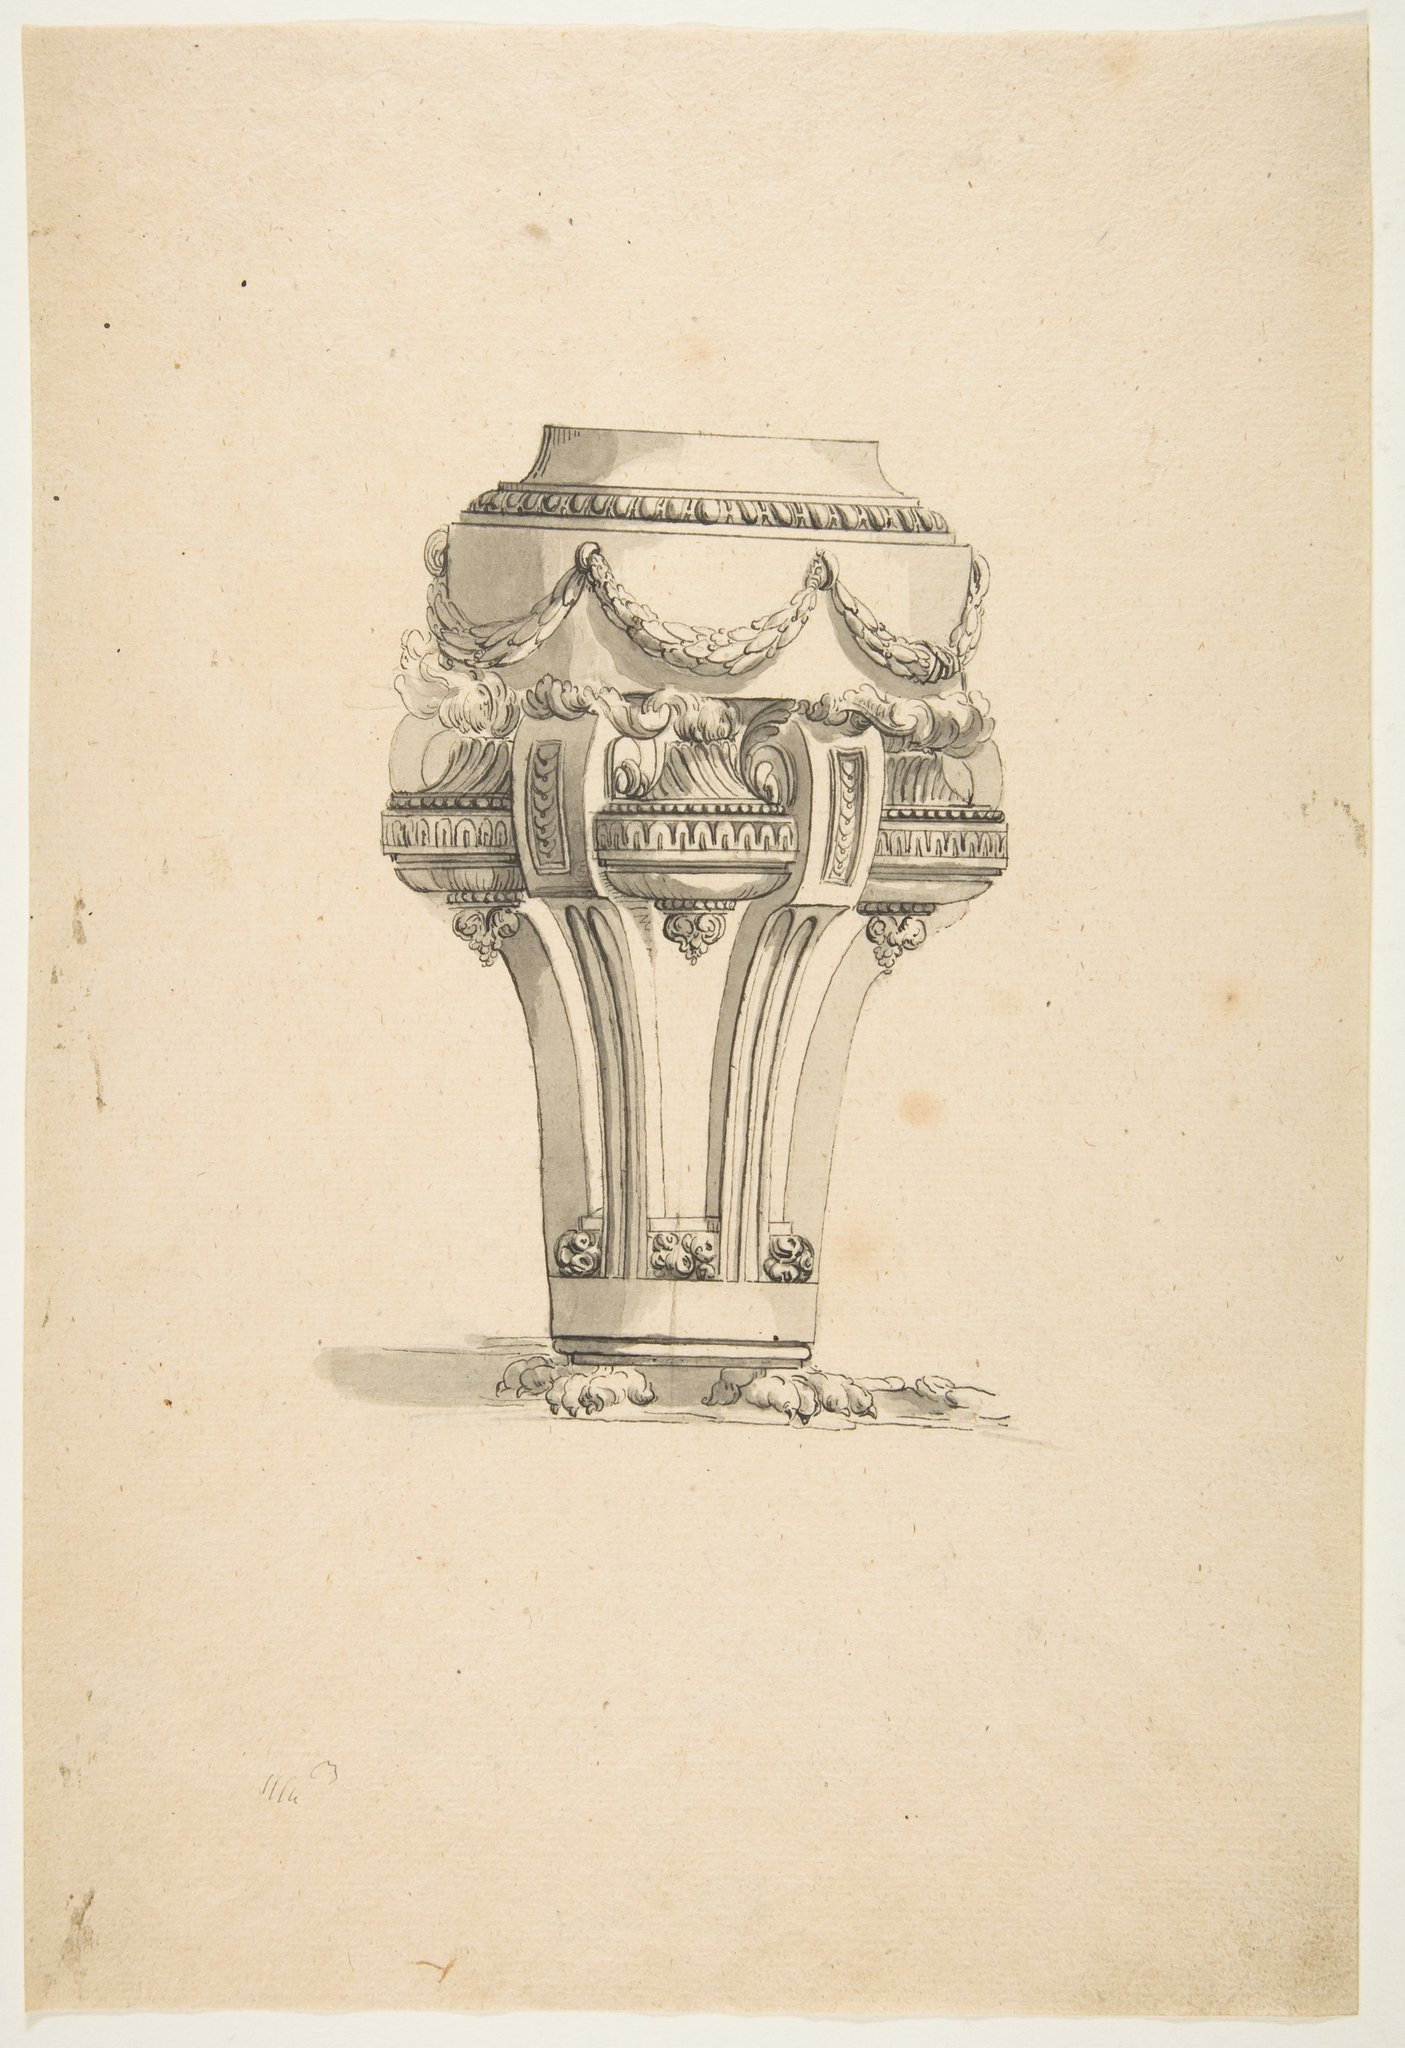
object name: drawing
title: Design for an Incense Burner (?)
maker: anonymous, french, 19th century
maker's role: artist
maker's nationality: french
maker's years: 1800-1900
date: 1801-1900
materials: ink, paper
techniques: pen, wash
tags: incense burners